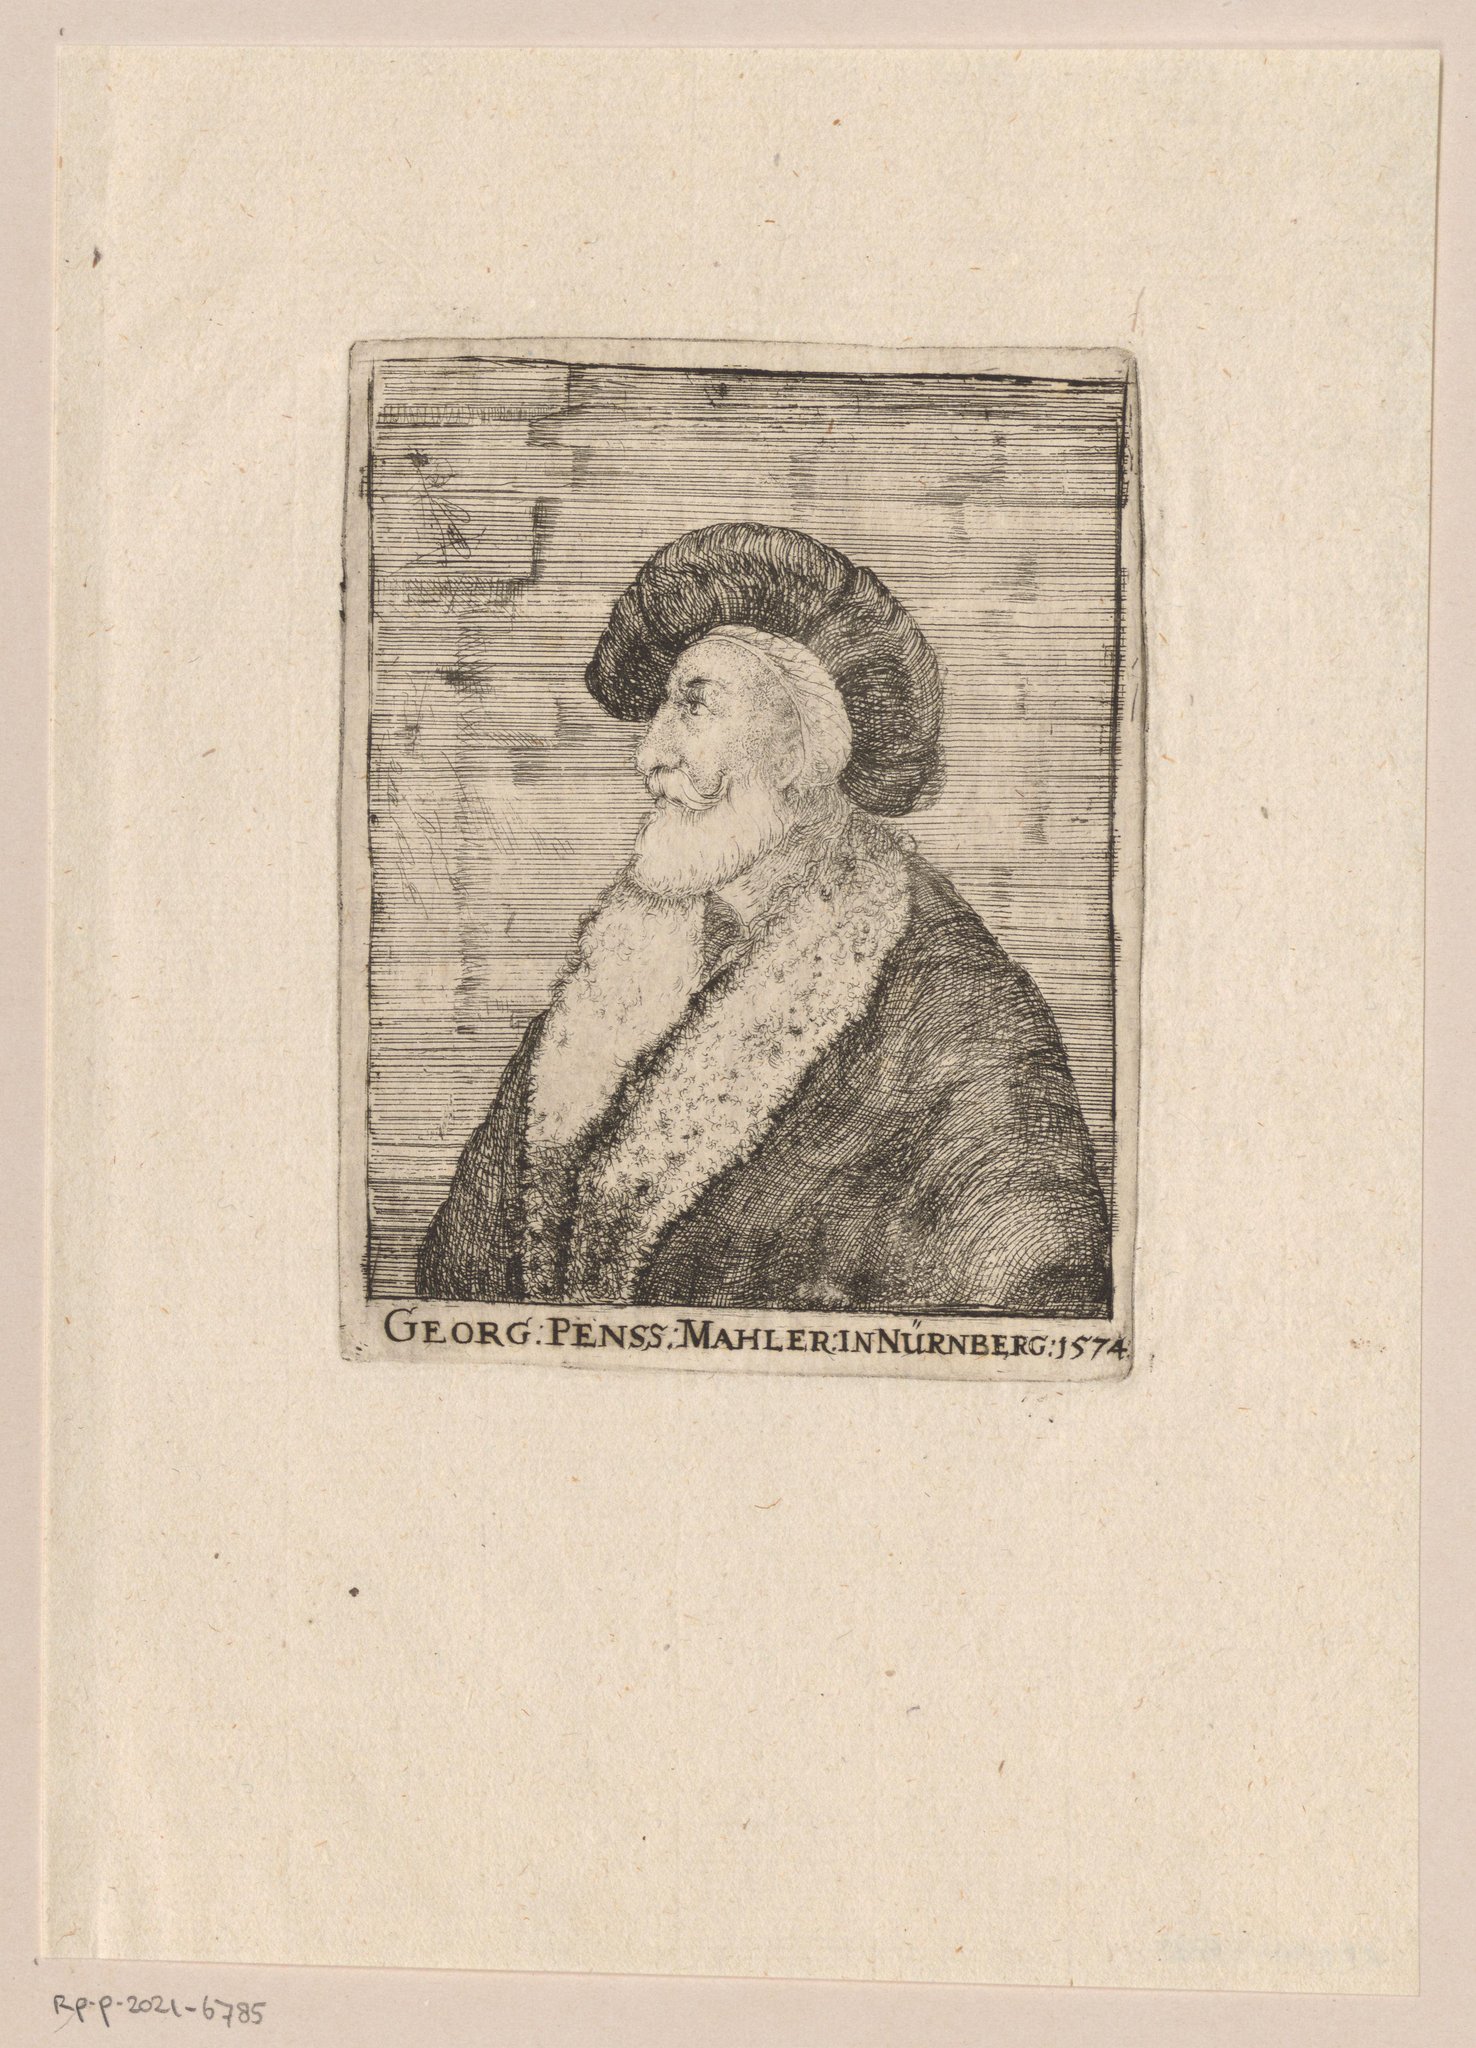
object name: print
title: Portret van Georg Pencz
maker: Anonymous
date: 1600-1699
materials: paper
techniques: etching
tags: painter, print maker, draughtsman, georg pencz, adult man, historical persons, portrait, self-portrait of artist, beard